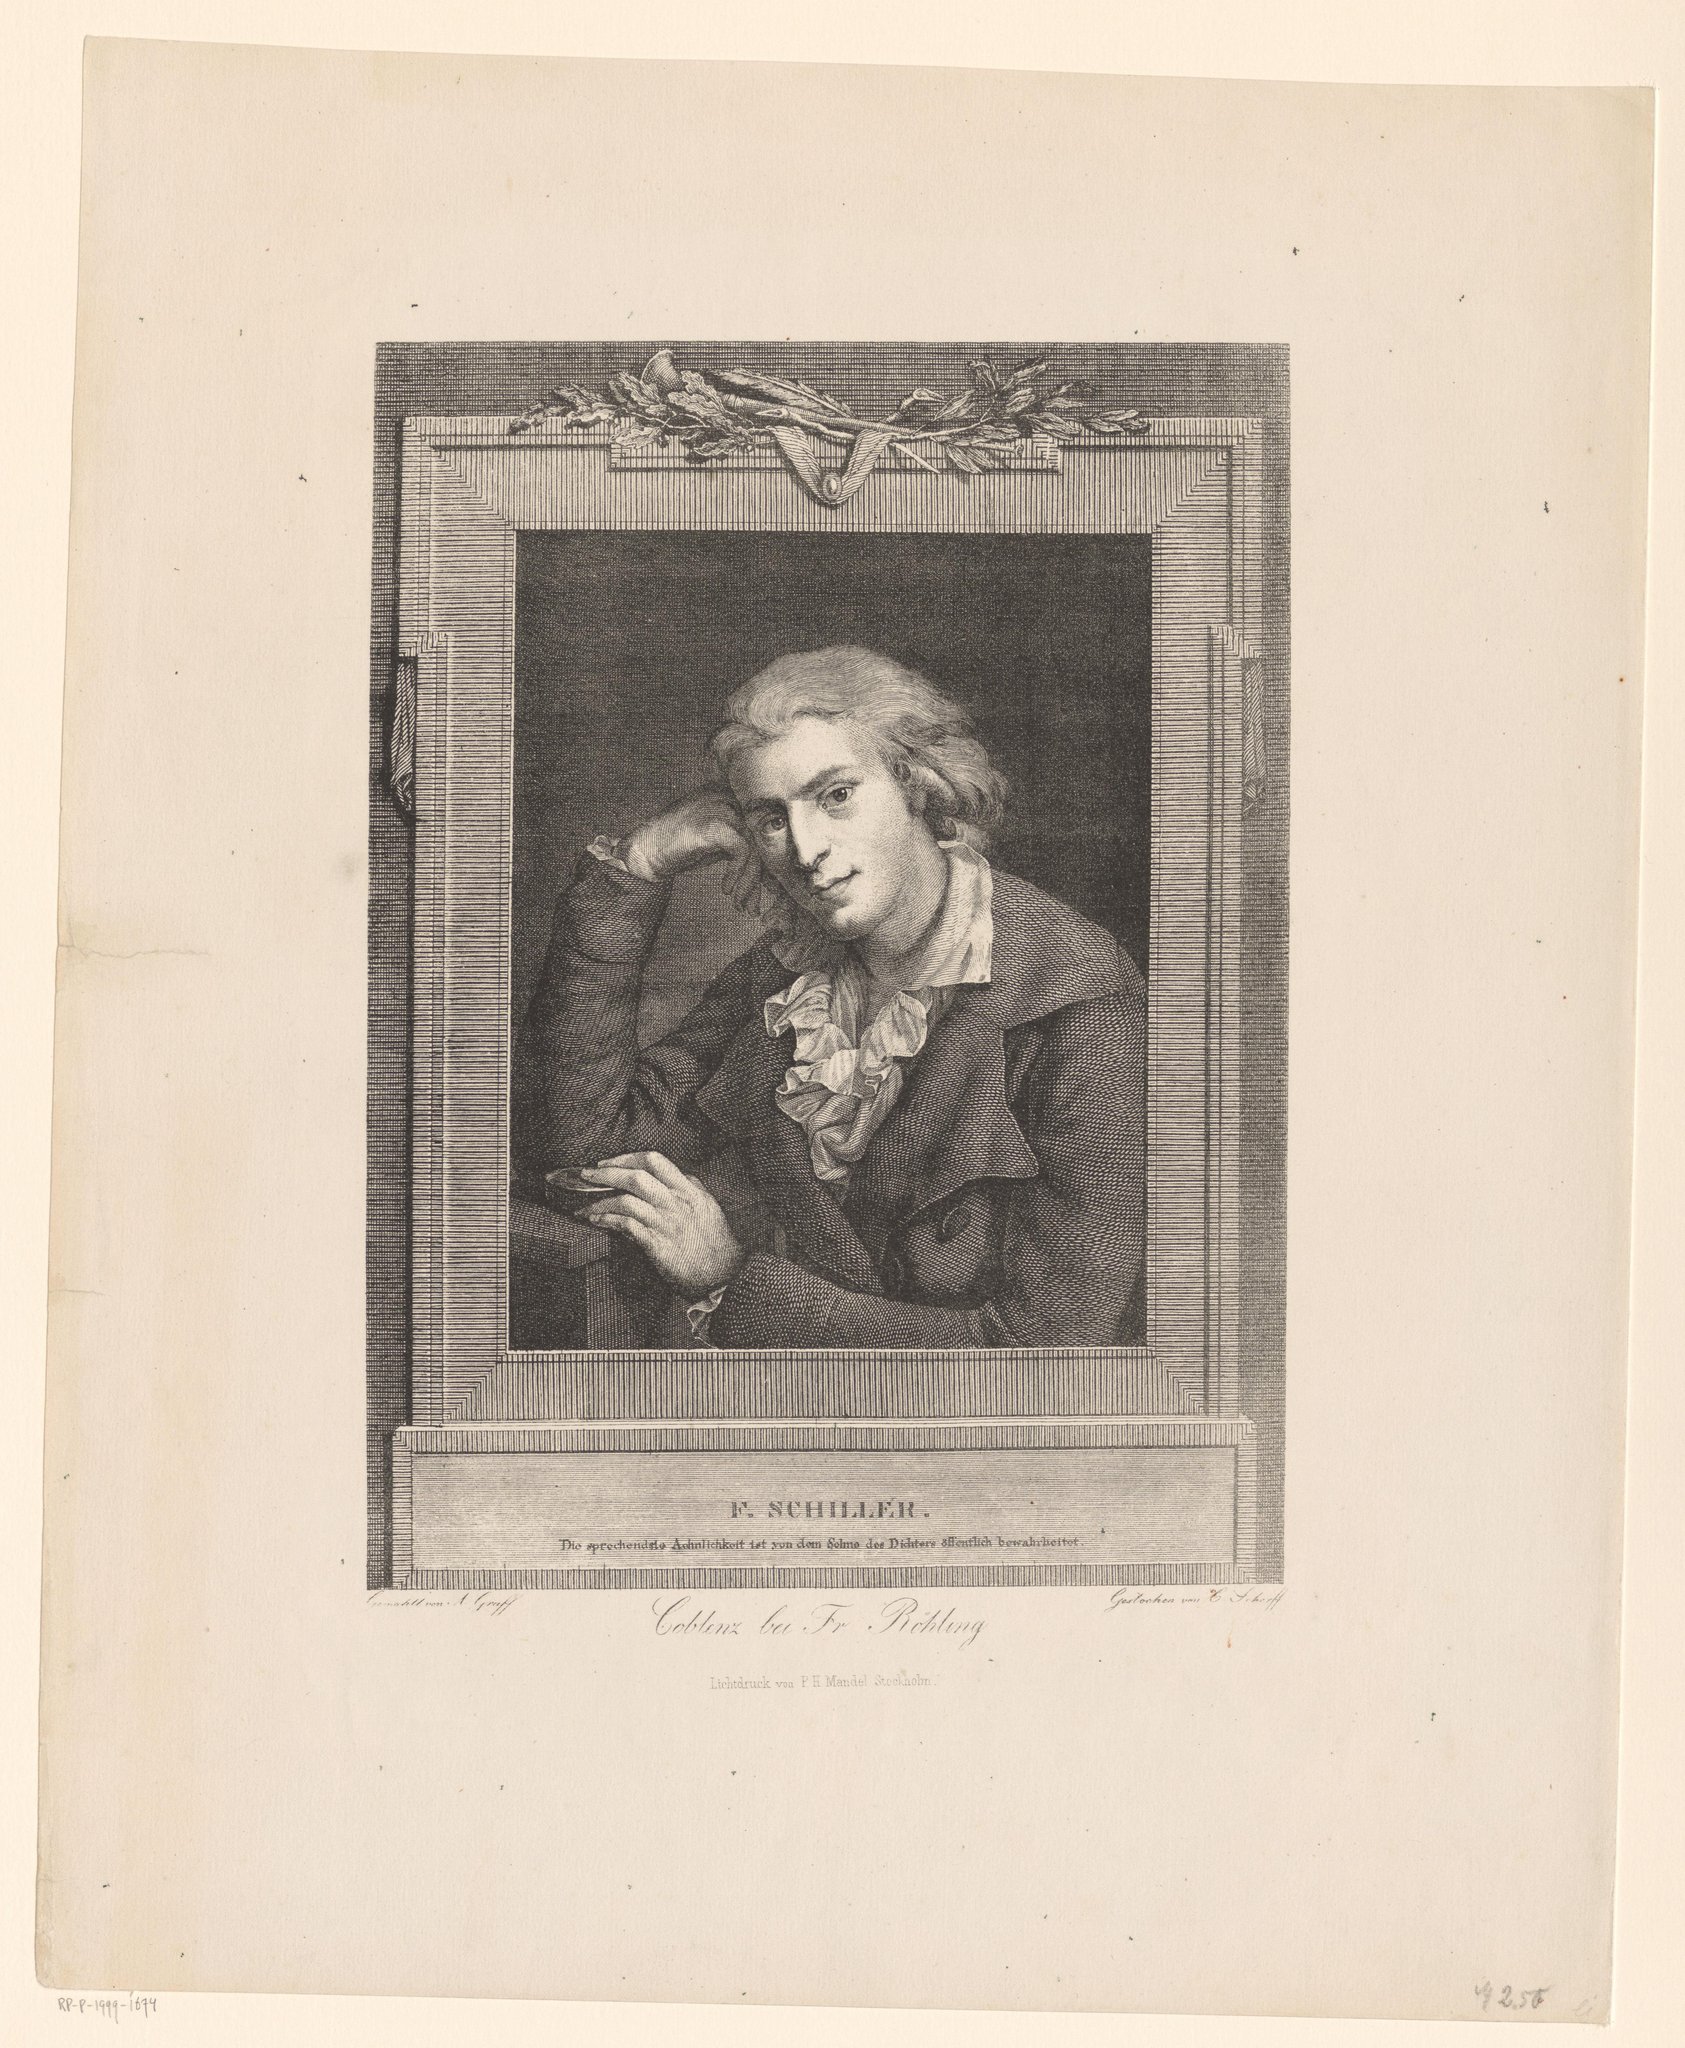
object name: photomechanical print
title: Portret van Friedrich von Schiller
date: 1875-1930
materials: paper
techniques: photograph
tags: friedrich von schiller, adult man, historical persons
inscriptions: collector's mark: Lugt 2760, collector's mark: Lugt 2228, collector's mark: Lugt 4100